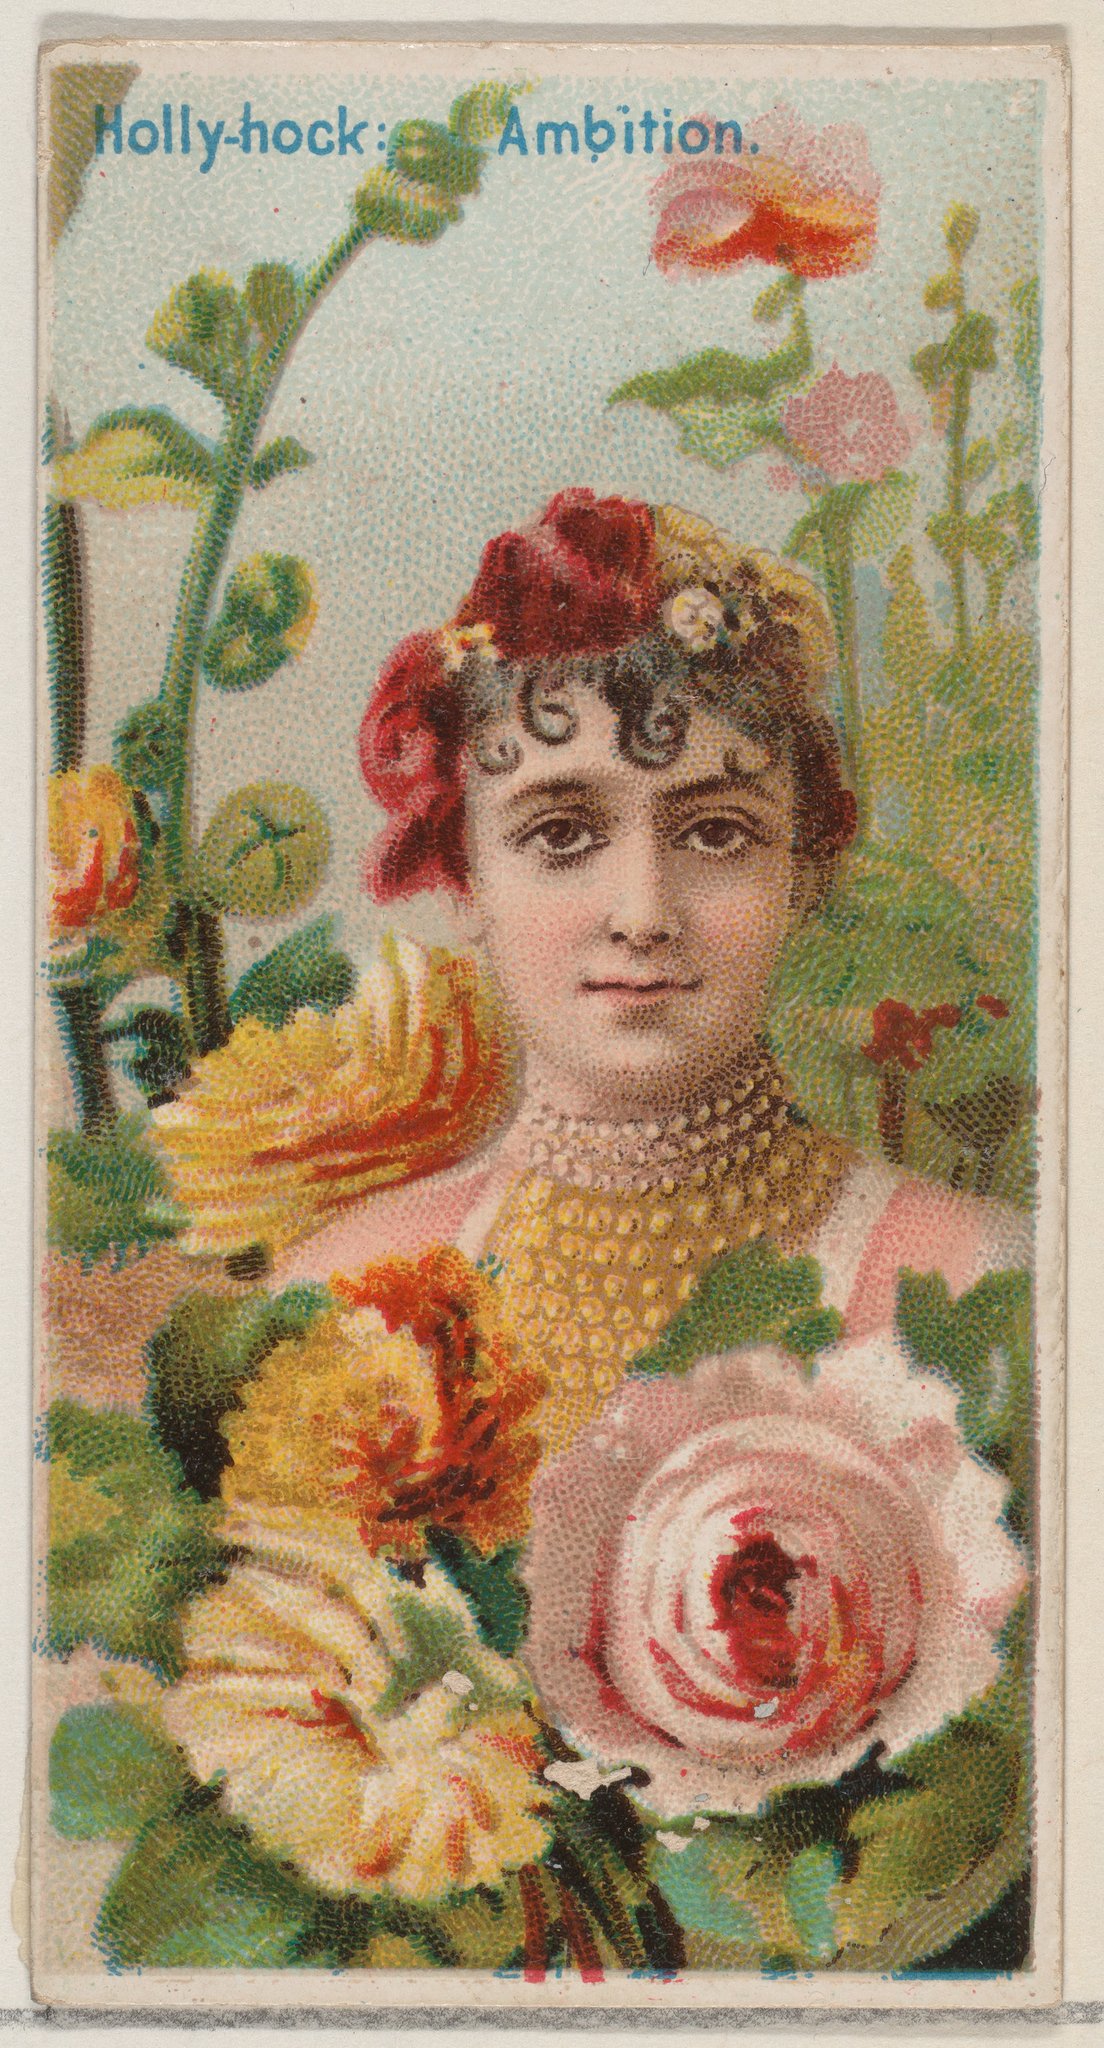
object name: print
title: Hollyhock: Ambition, from the series Floral Beauties and Language of Flowers (N75) for Duke brand cigarettes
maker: american tobacco company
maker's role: publisher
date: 1892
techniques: color lithograph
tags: women,flowers